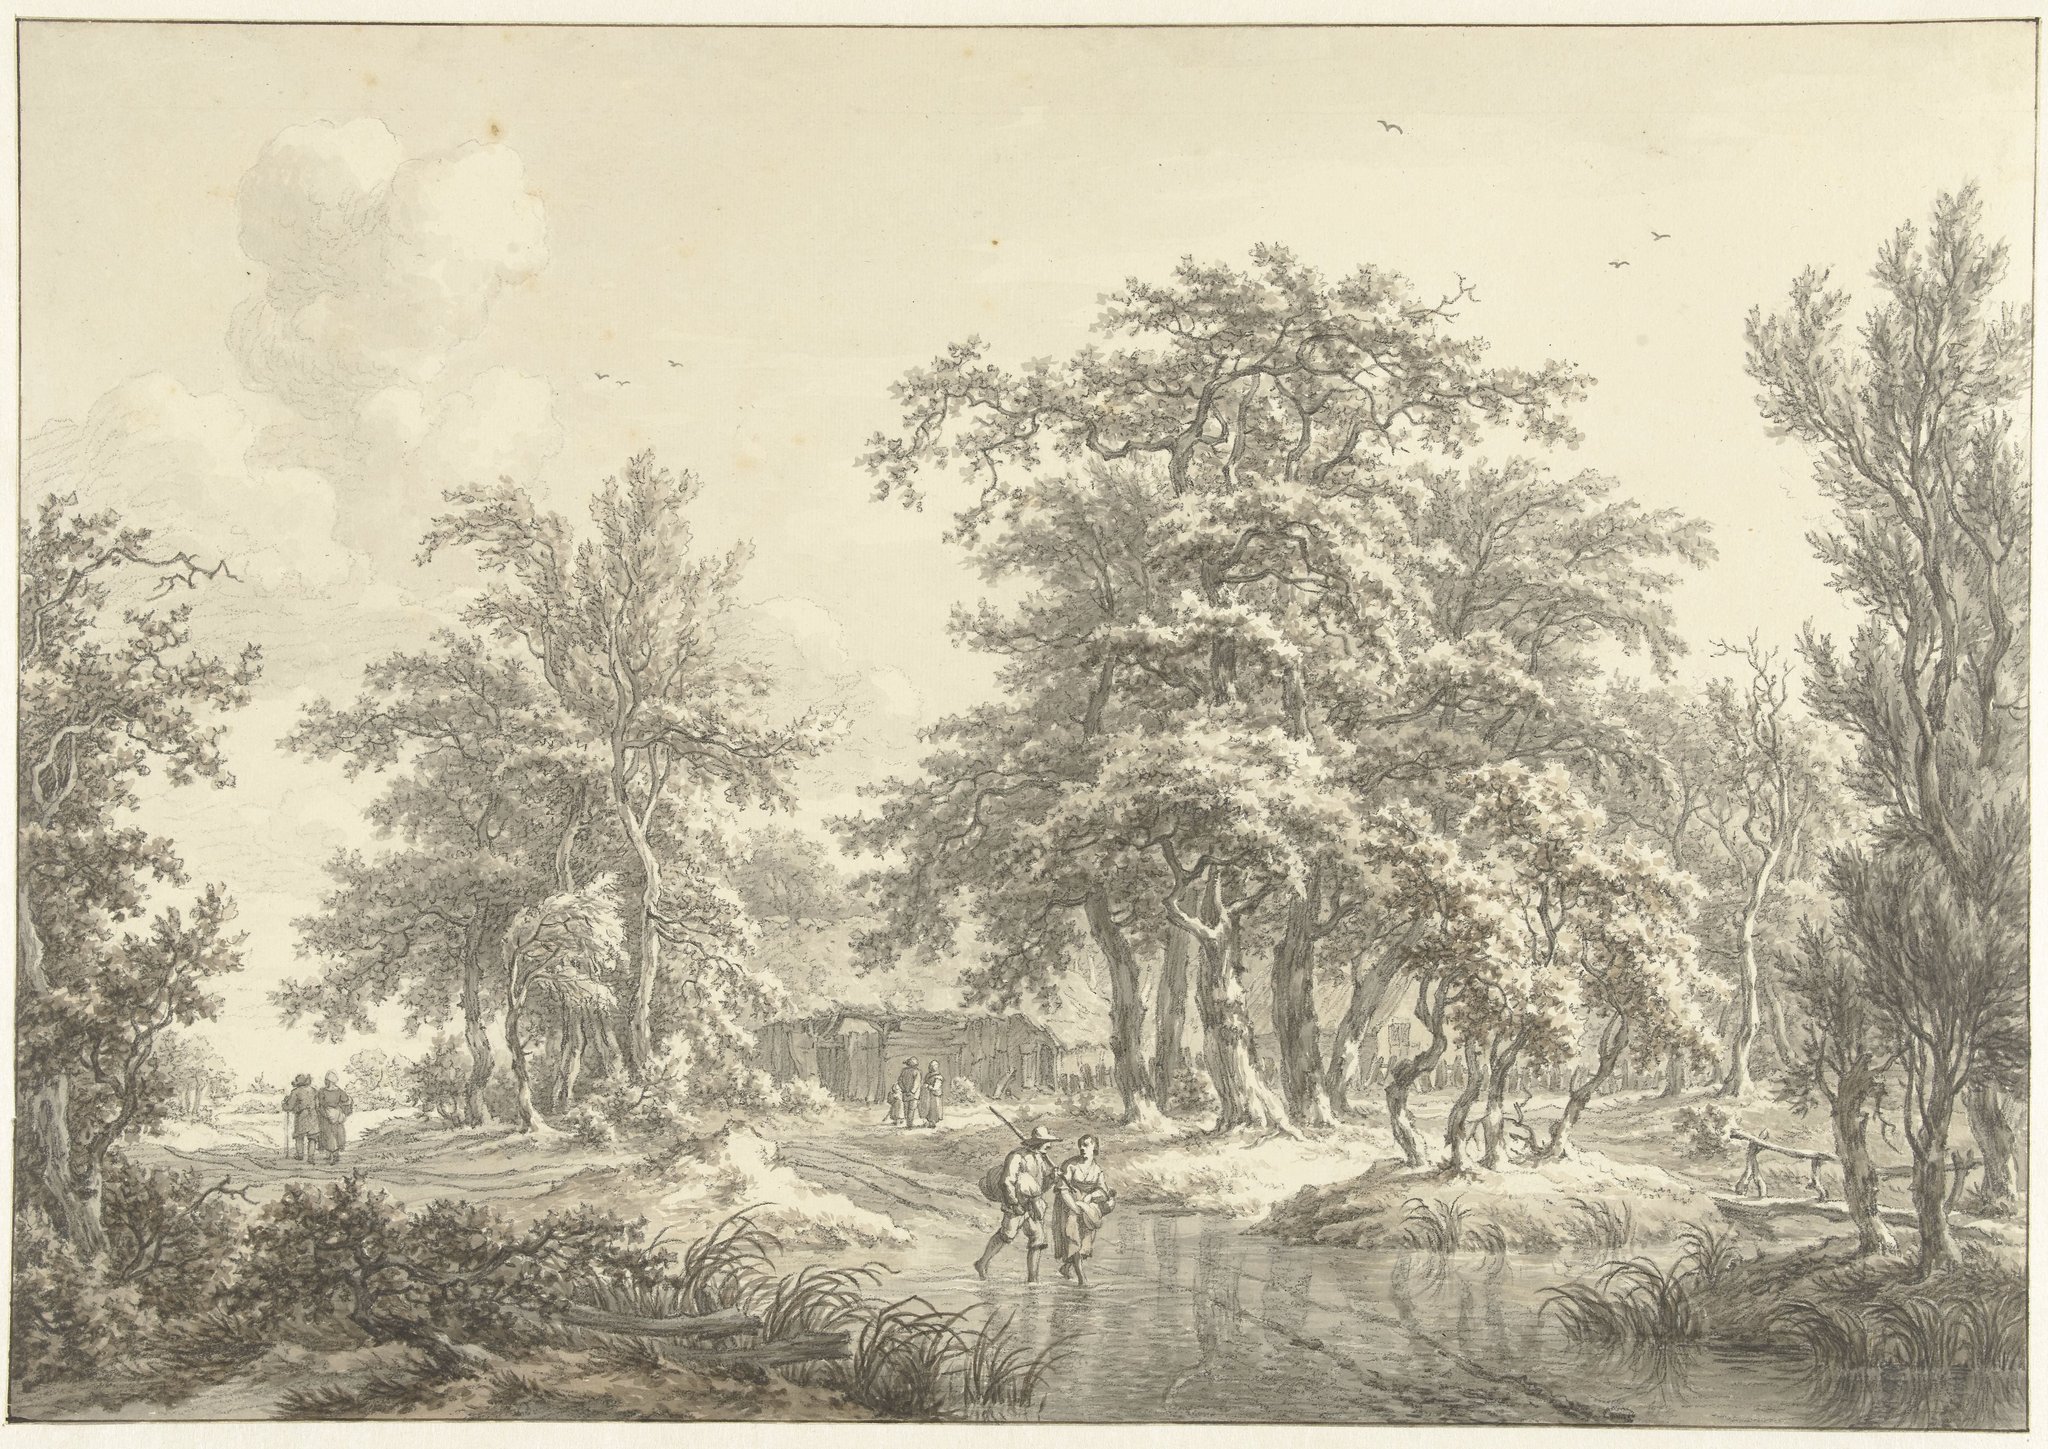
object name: drawing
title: Boomrijk landschap met enkele groepjes figuren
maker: egbert van drielst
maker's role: draughtsman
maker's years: 1745-1818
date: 1786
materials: chalk, paper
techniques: brush